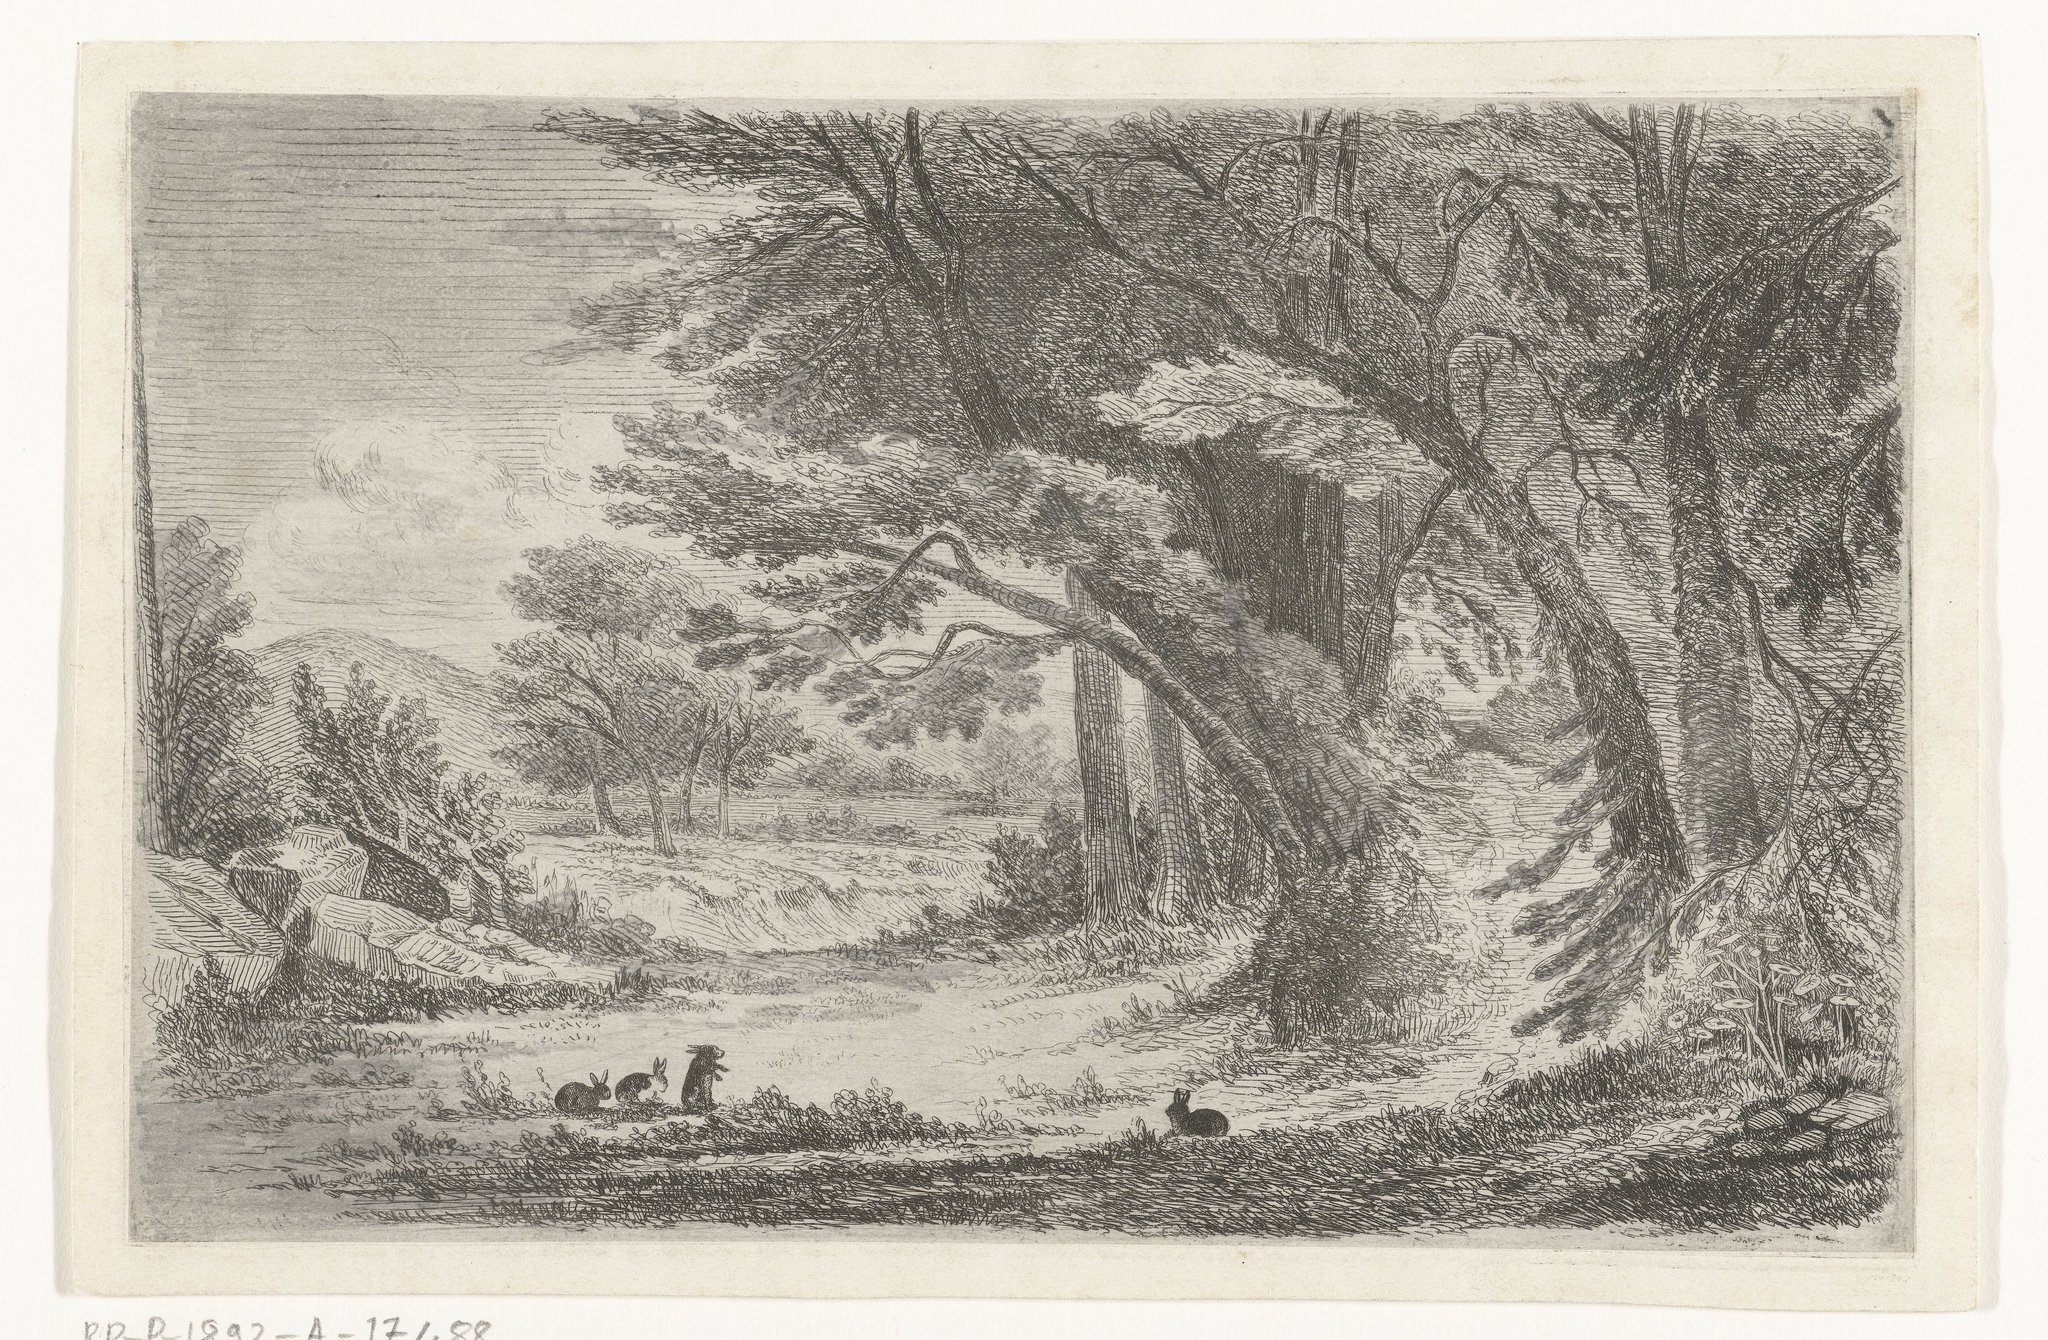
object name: print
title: Bosrand met konijnen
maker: jan bos wz.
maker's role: print maker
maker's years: 1832-1897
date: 1847-1892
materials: paper, pencil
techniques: etching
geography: utrecht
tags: fringe, edge of the wood (+ landscape with figures, staffage)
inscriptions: collector's mark: Lugt 2228